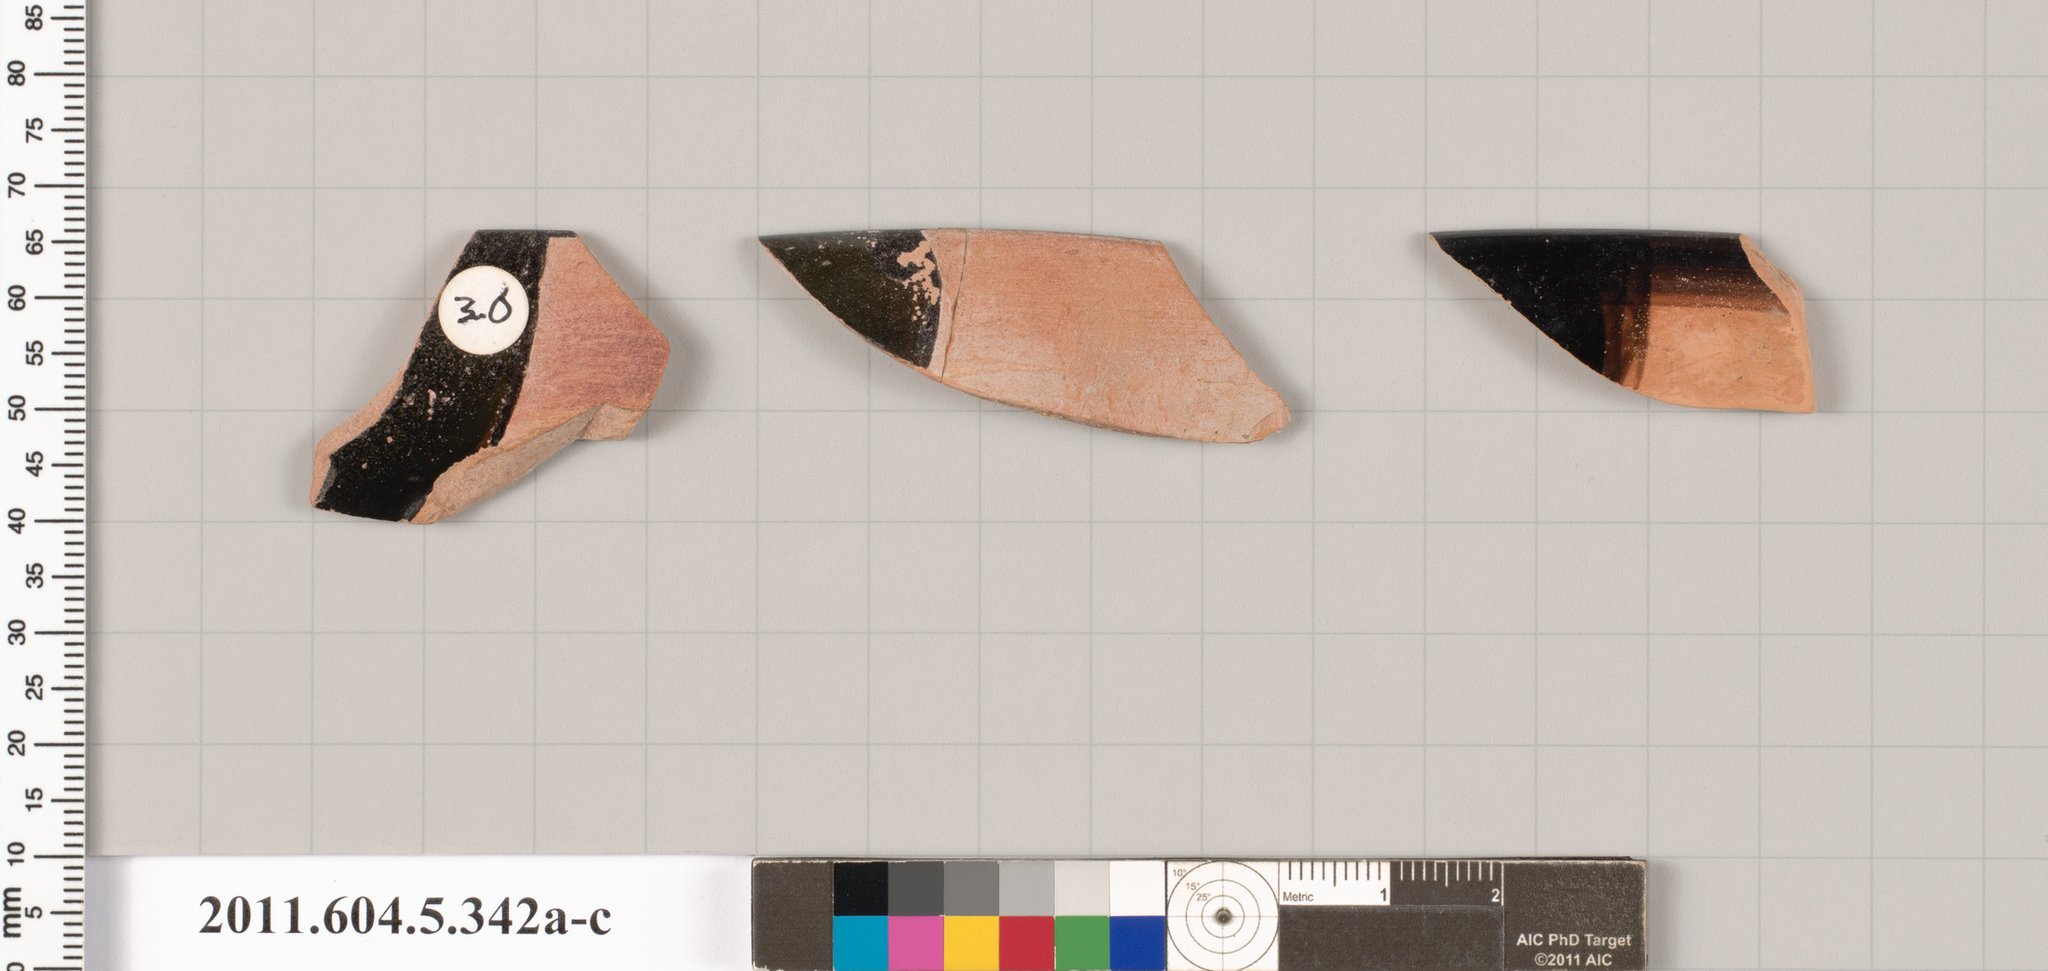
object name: kylix fragment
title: Terracotta rim fragments of kylikes (drinking cups)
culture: greek, attic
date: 600-401 BCE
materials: terracotta